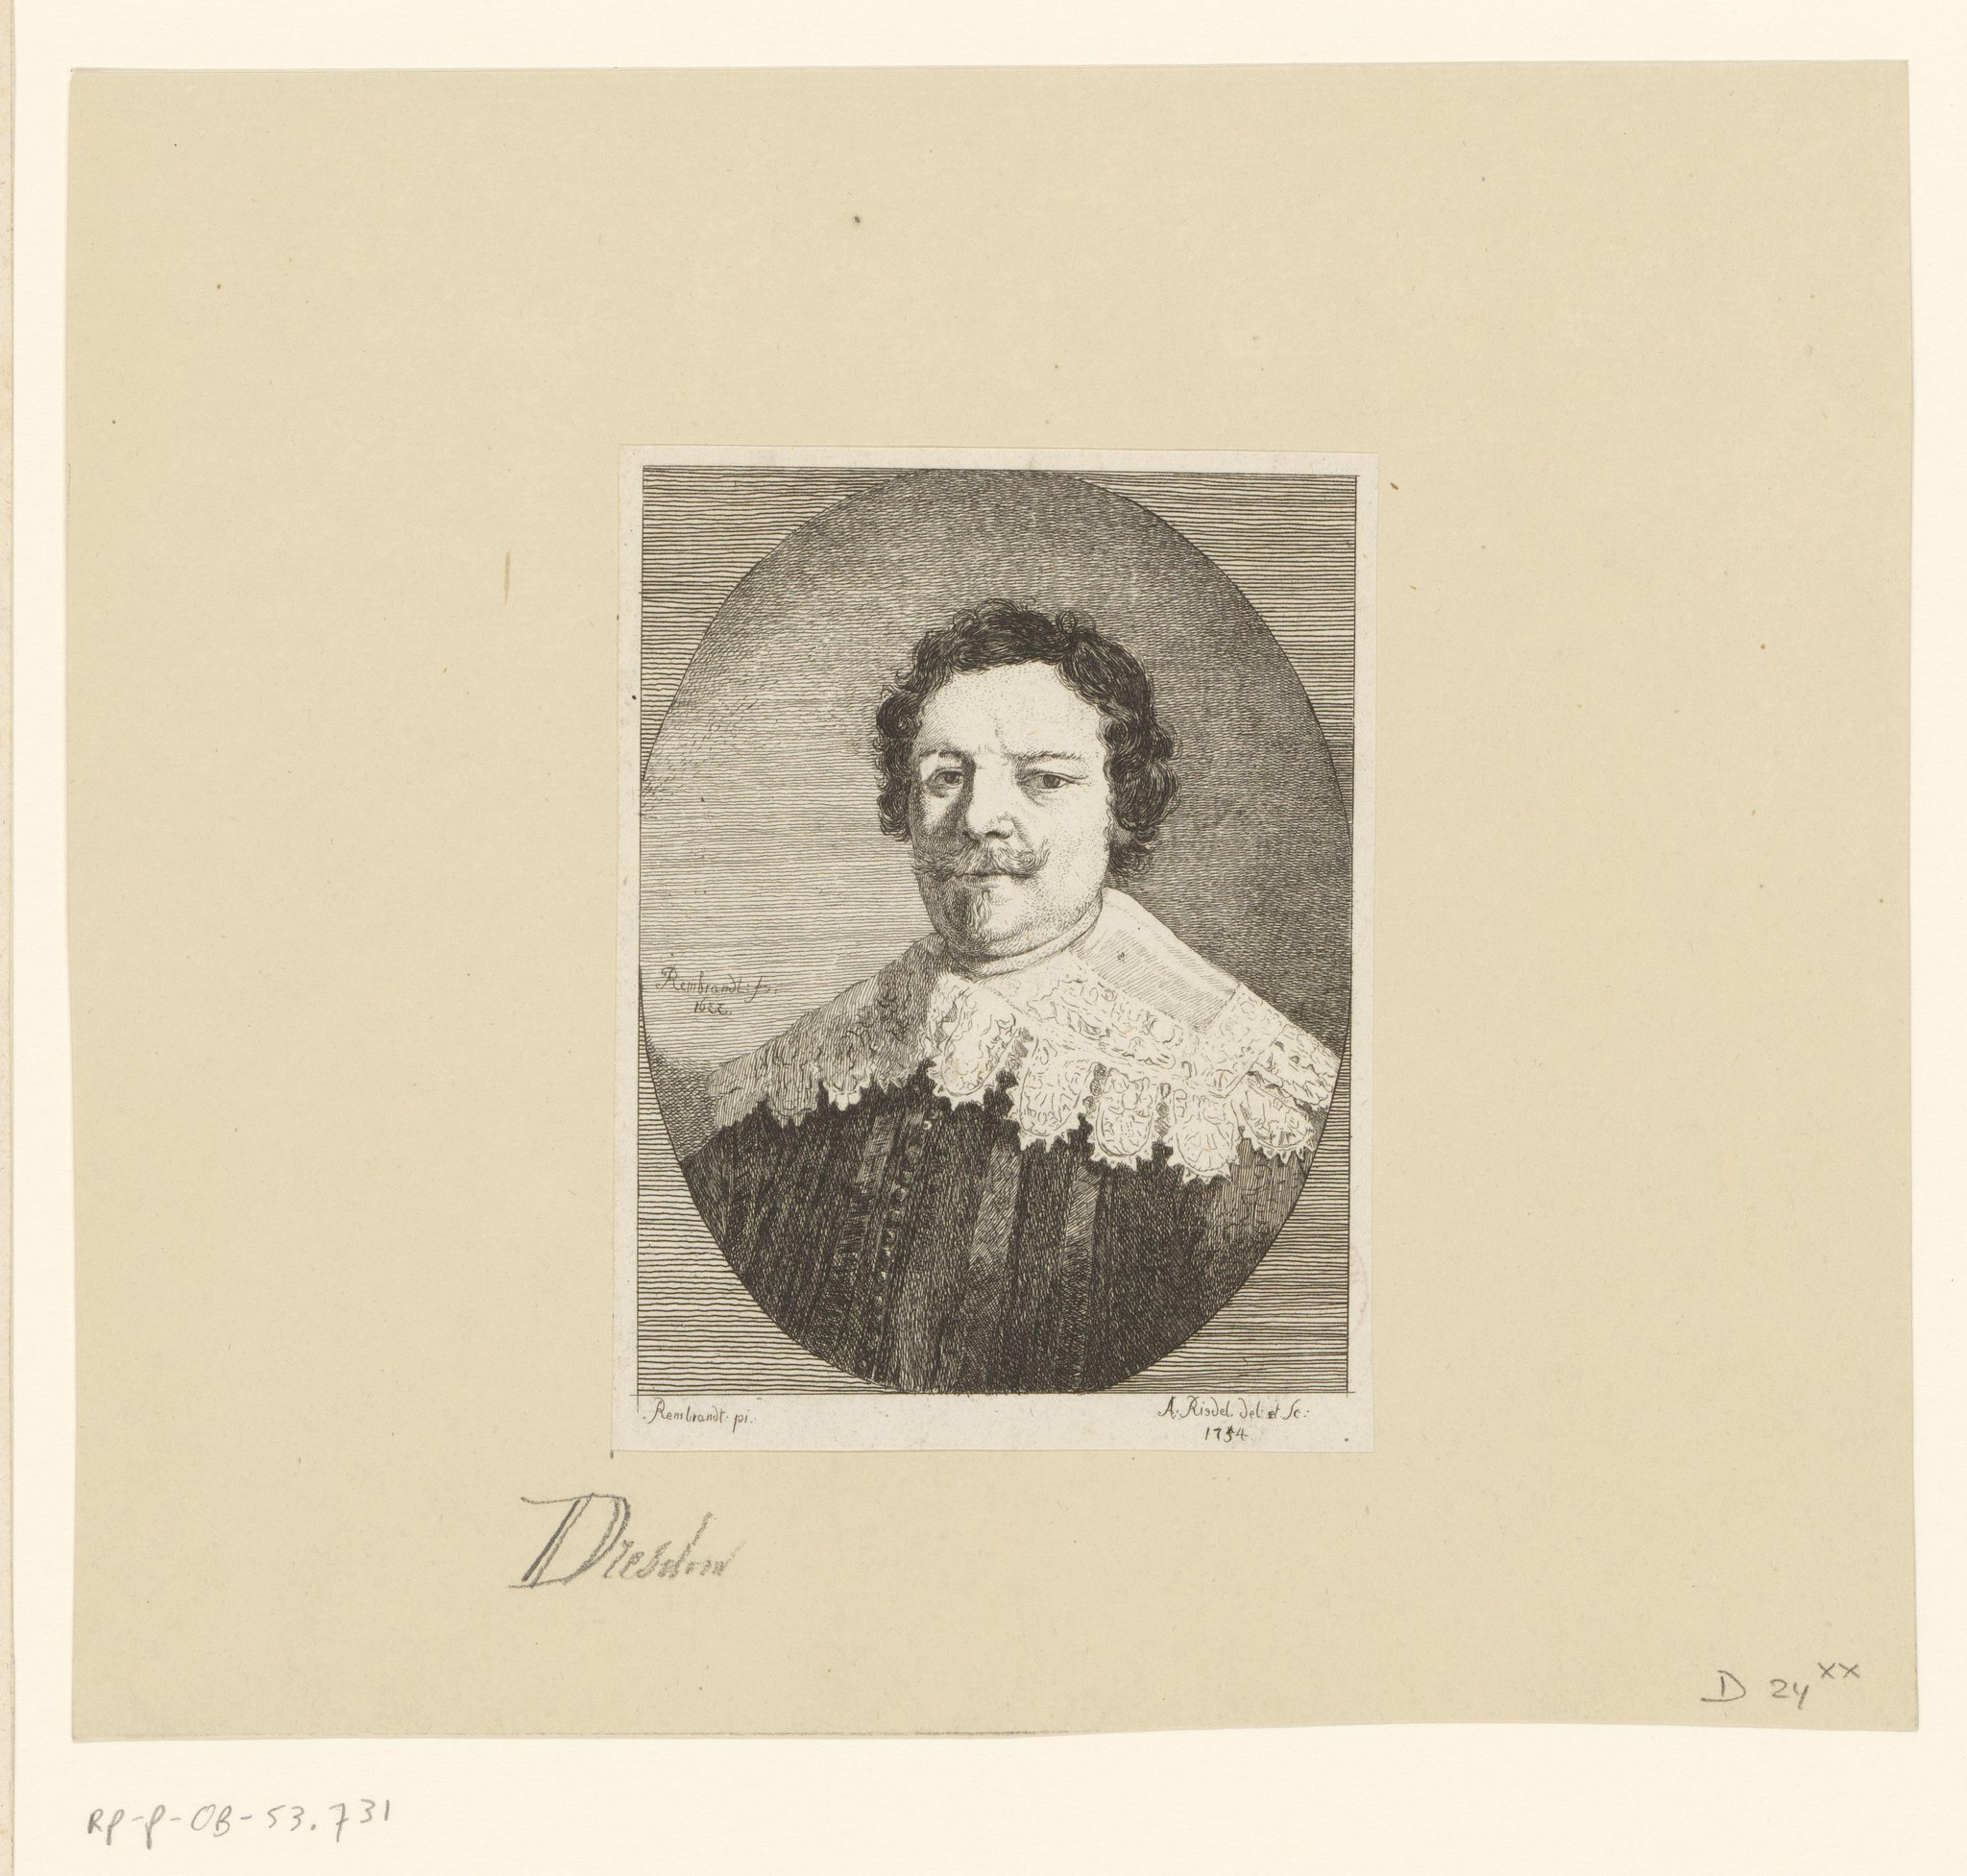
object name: print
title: Portret van een onbekende man met kanten kraag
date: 1754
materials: paper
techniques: etching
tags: adult man, lace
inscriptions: collector's mark: Lugt 2228